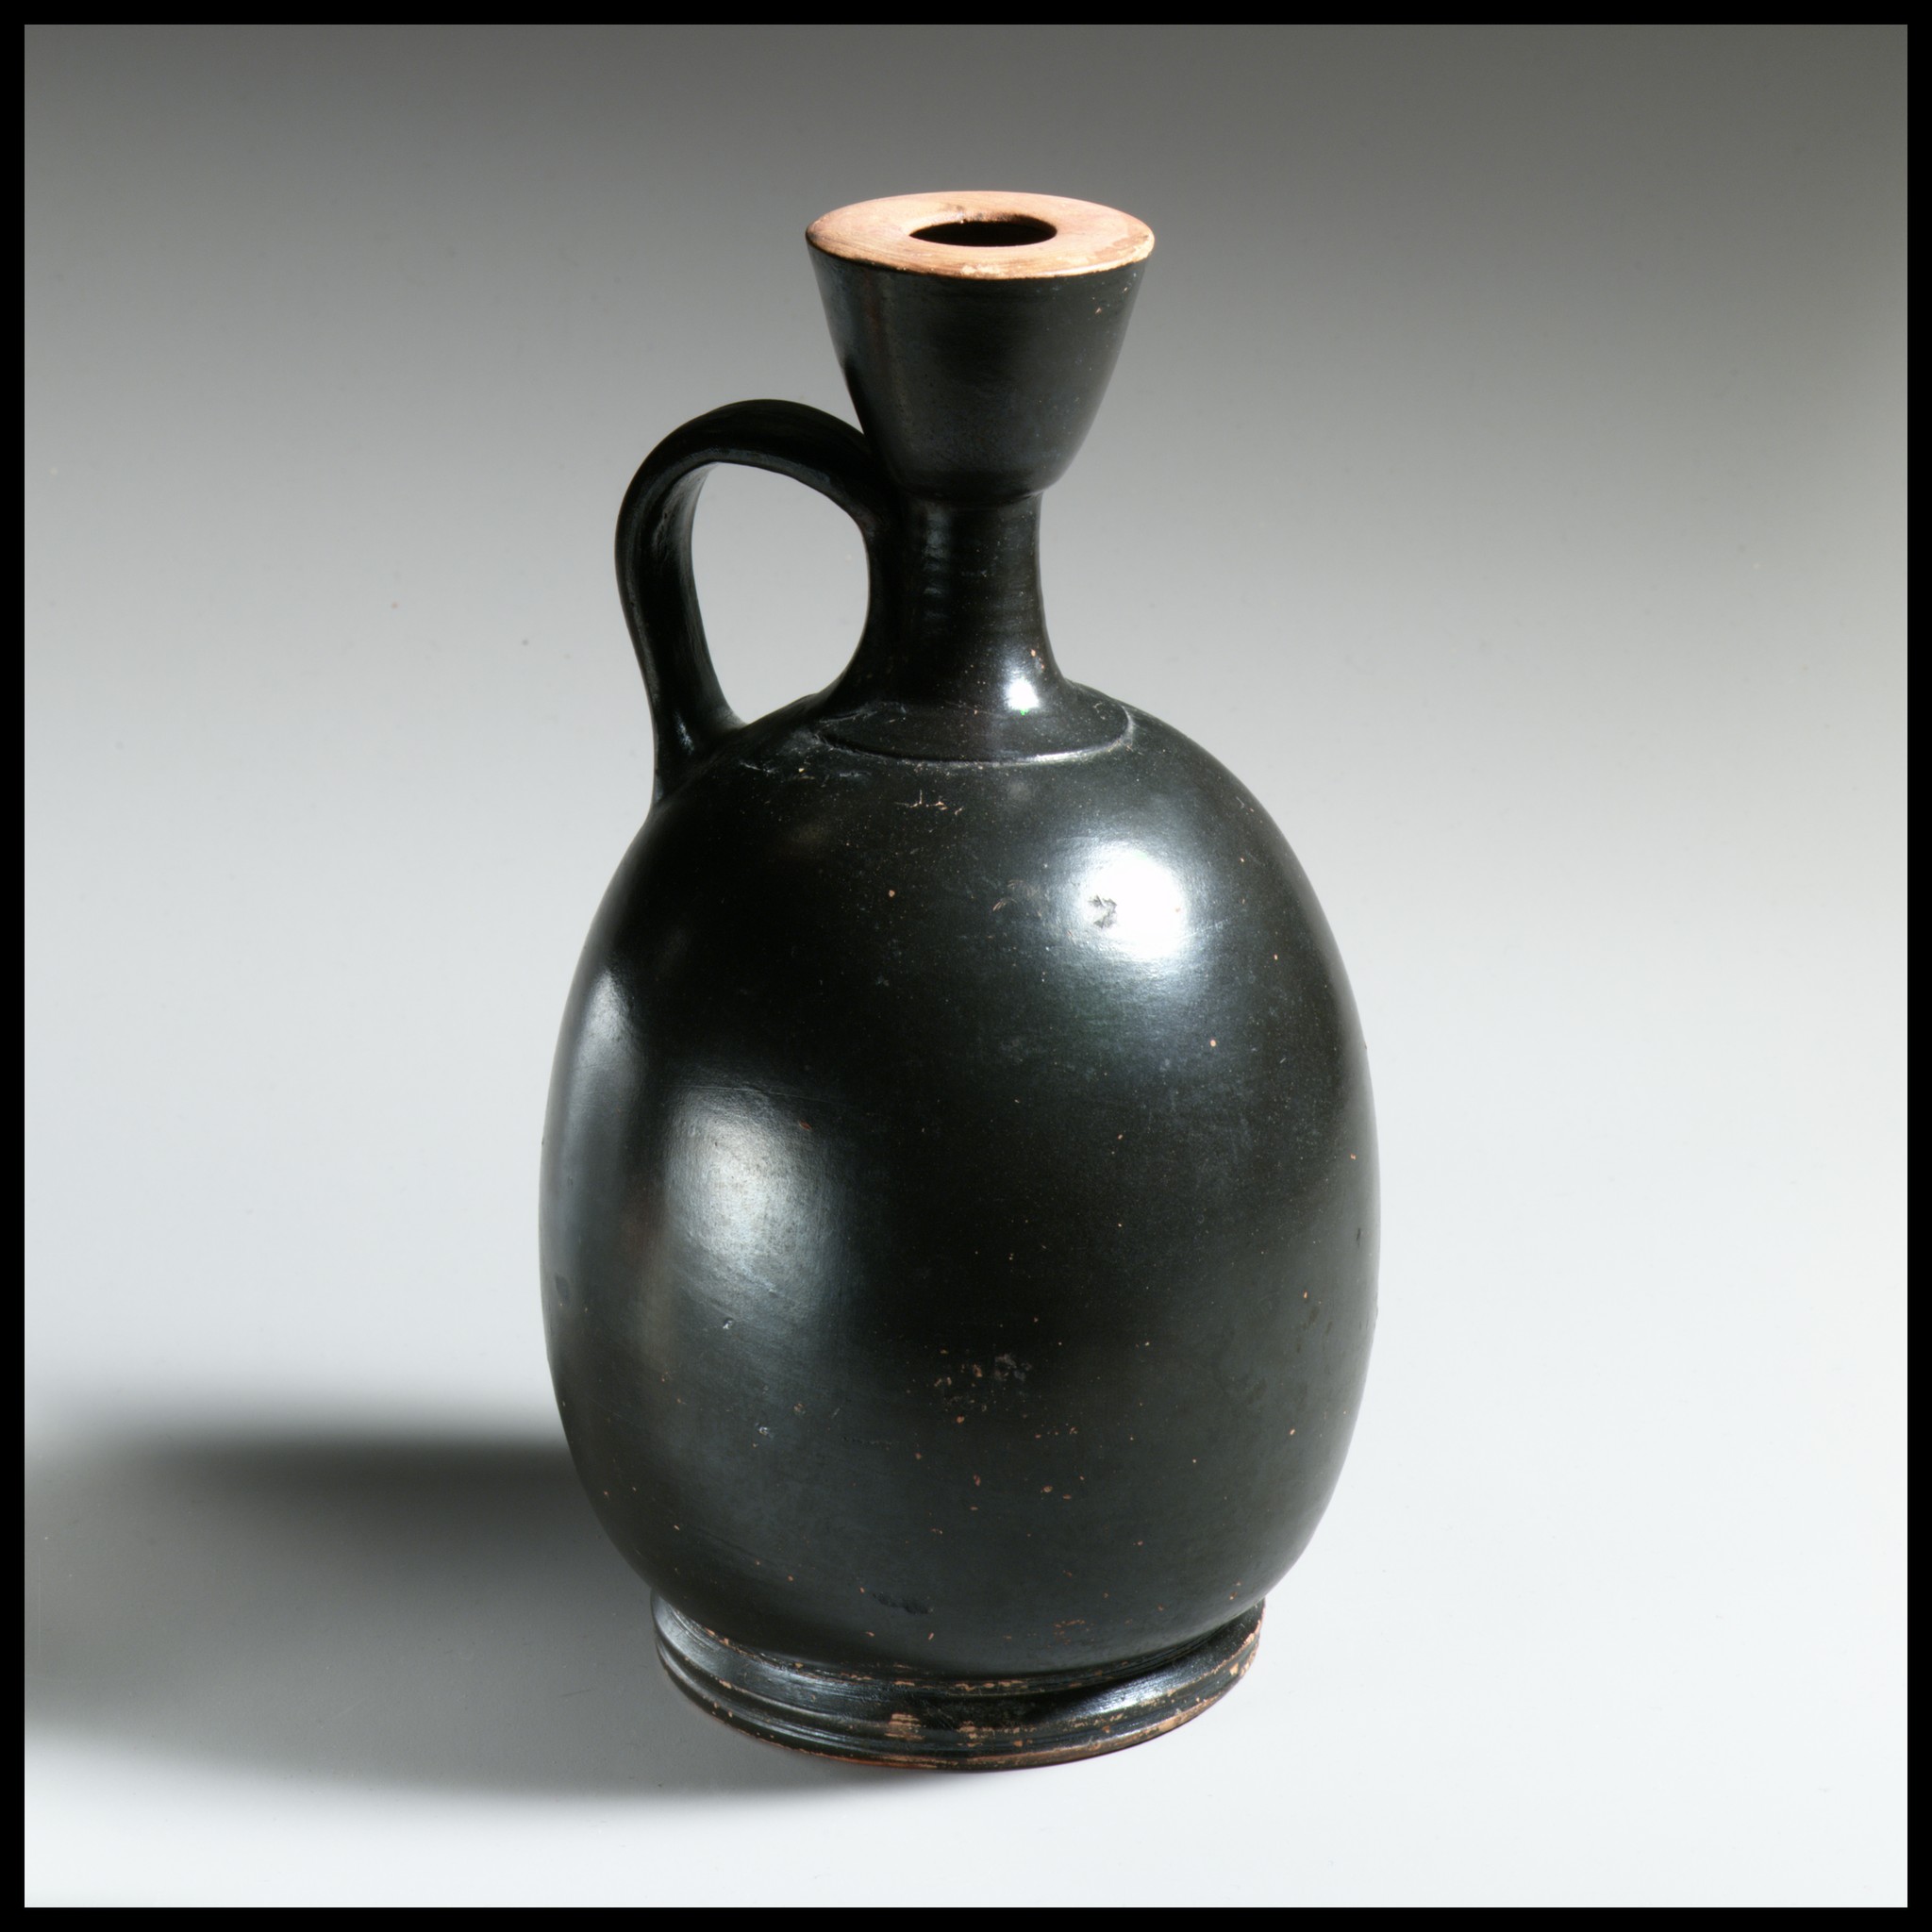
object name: squat lekythos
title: Terracotta squat lekythos (oil flask)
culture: greek, attic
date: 500-401 BCE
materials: terracotta